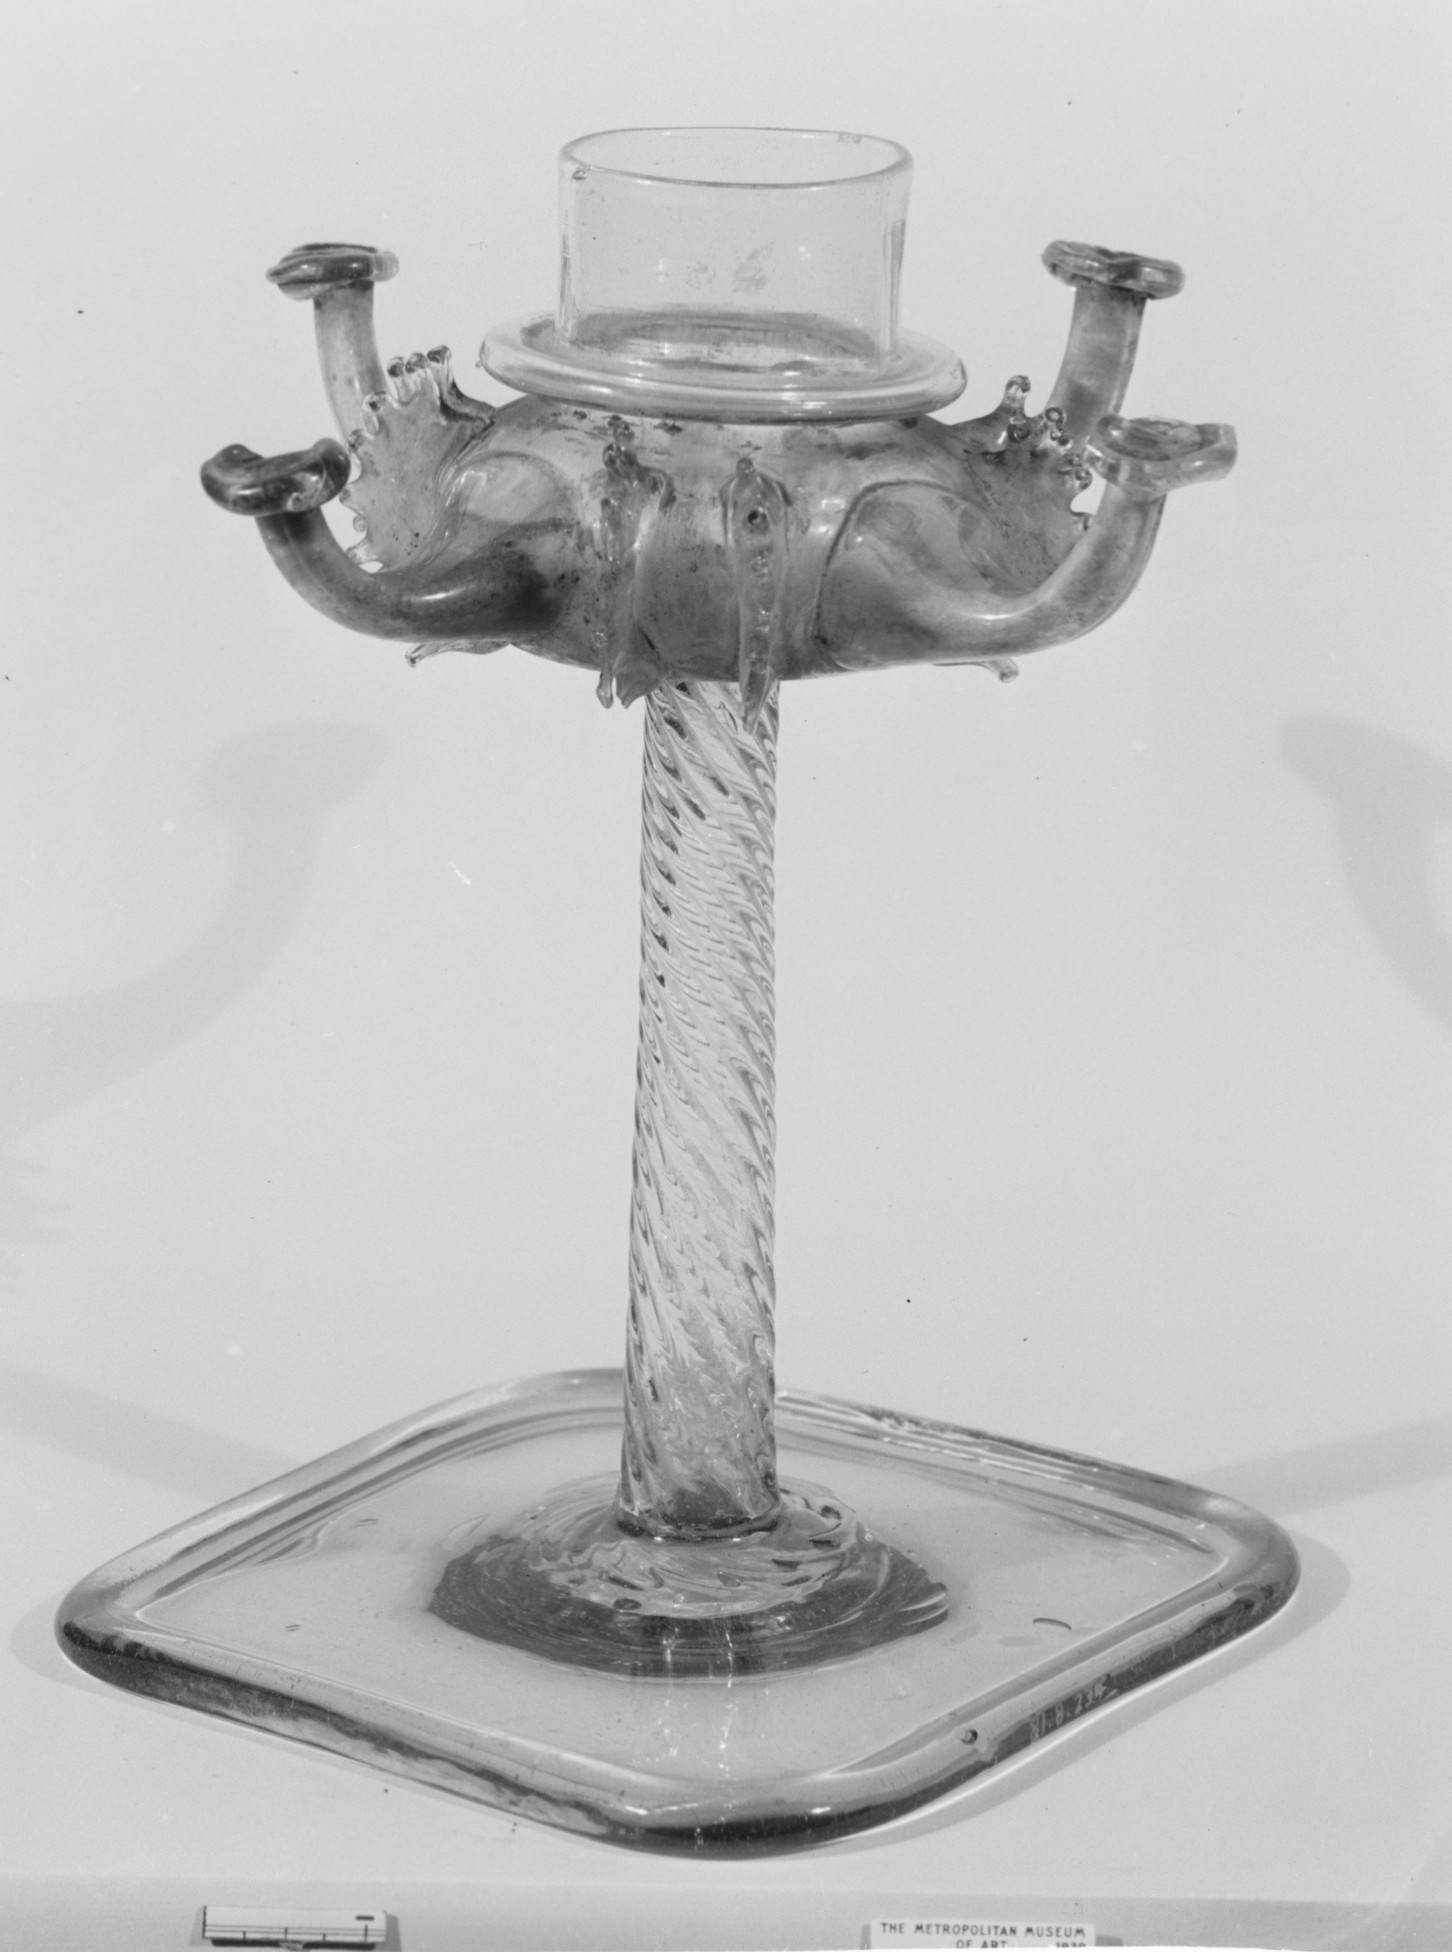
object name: lamp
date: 1701-1800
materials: glass